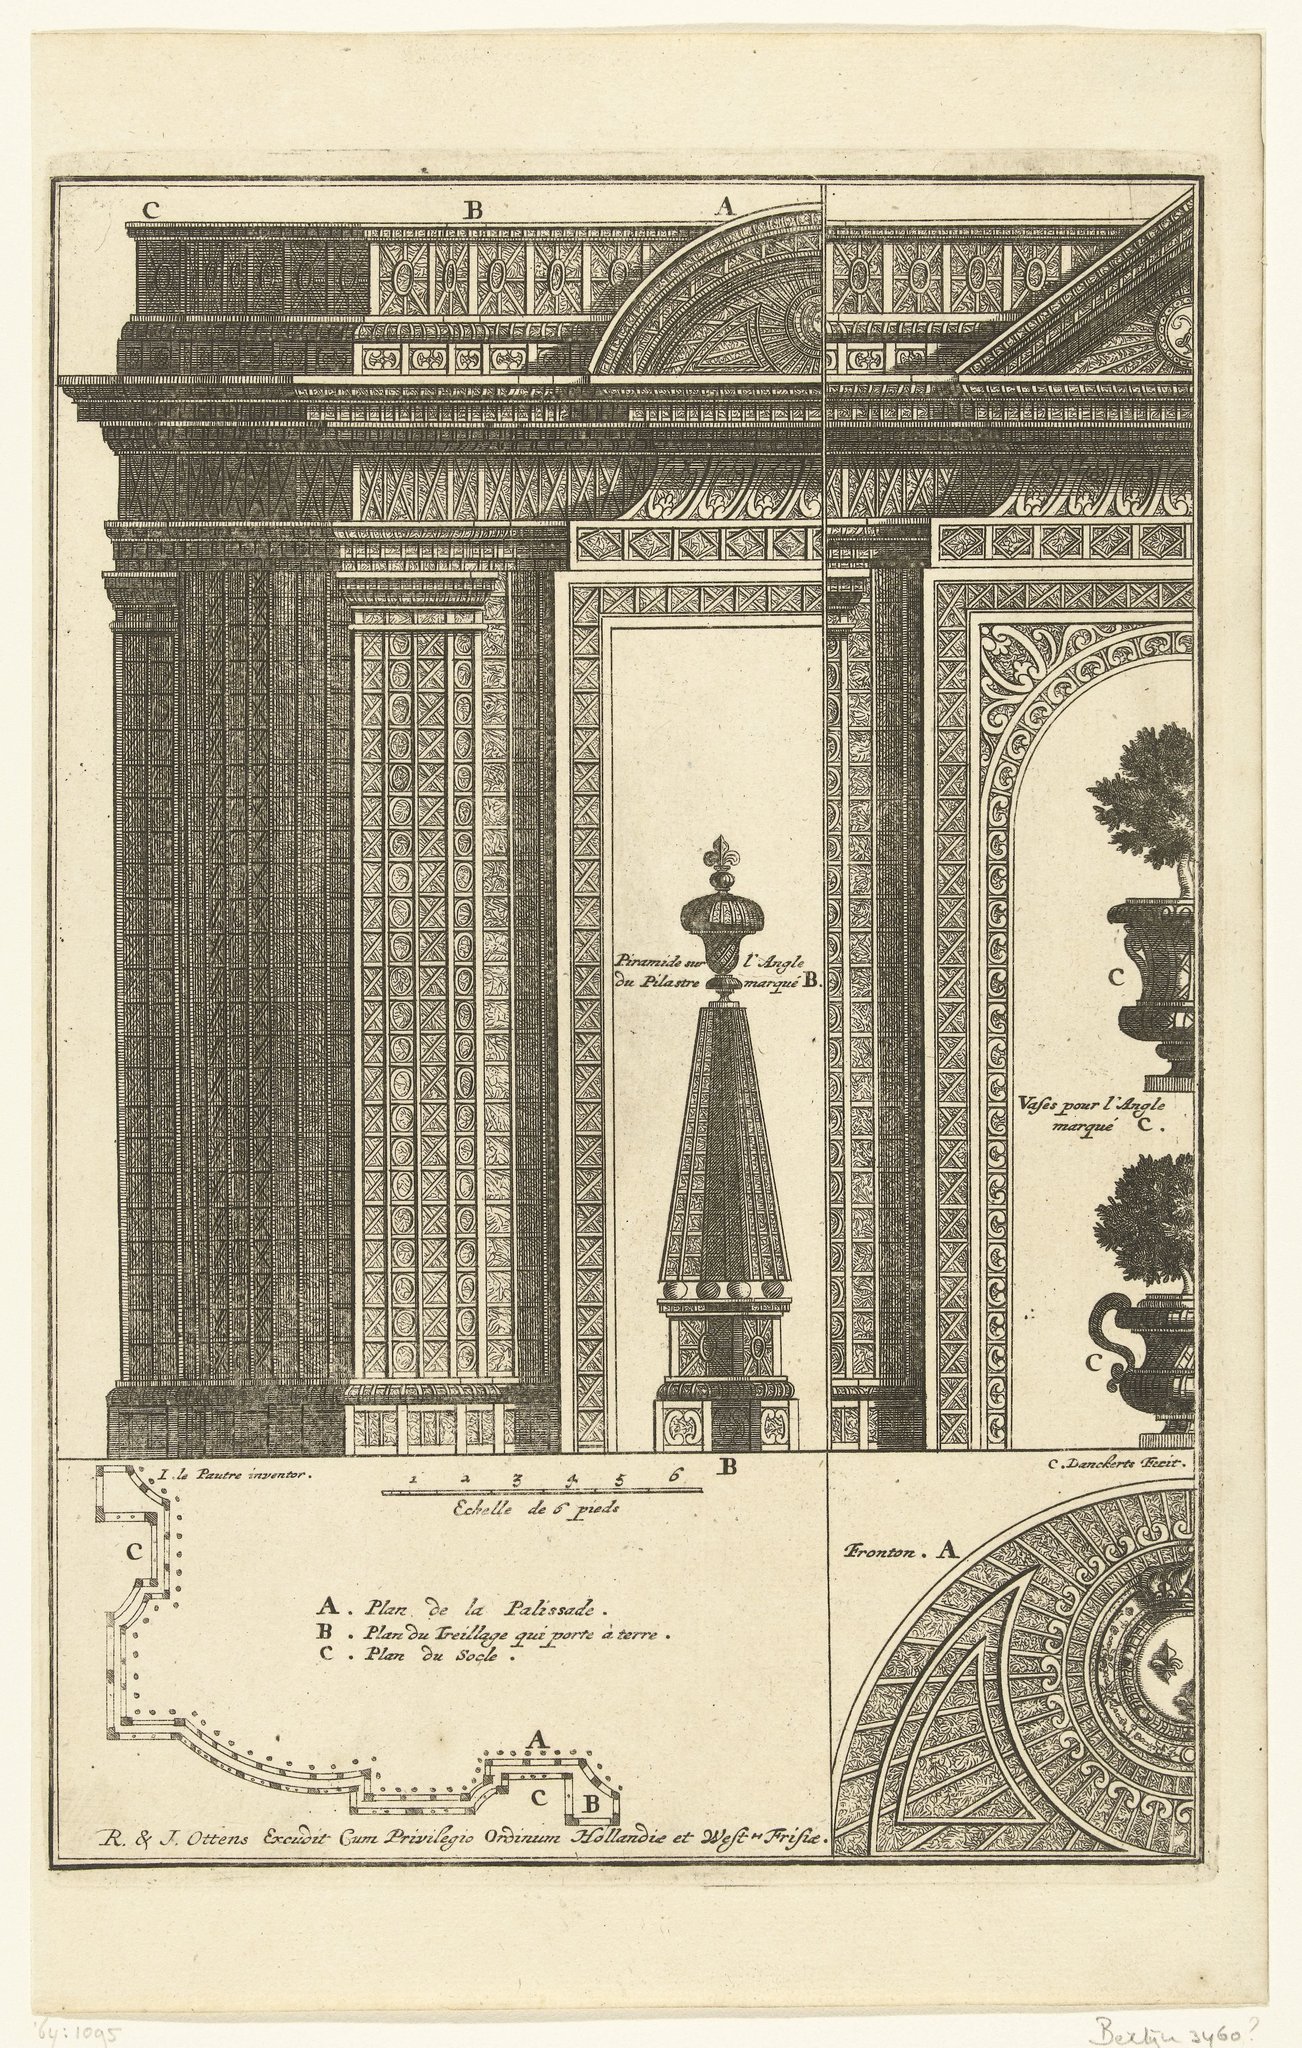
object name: ornament print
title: Latwerkpaviljoens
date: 1726-1750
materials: paper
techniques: etching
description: Met opstand, plan en detail van het voetstuk met het Franse koninklijke wapenschild.